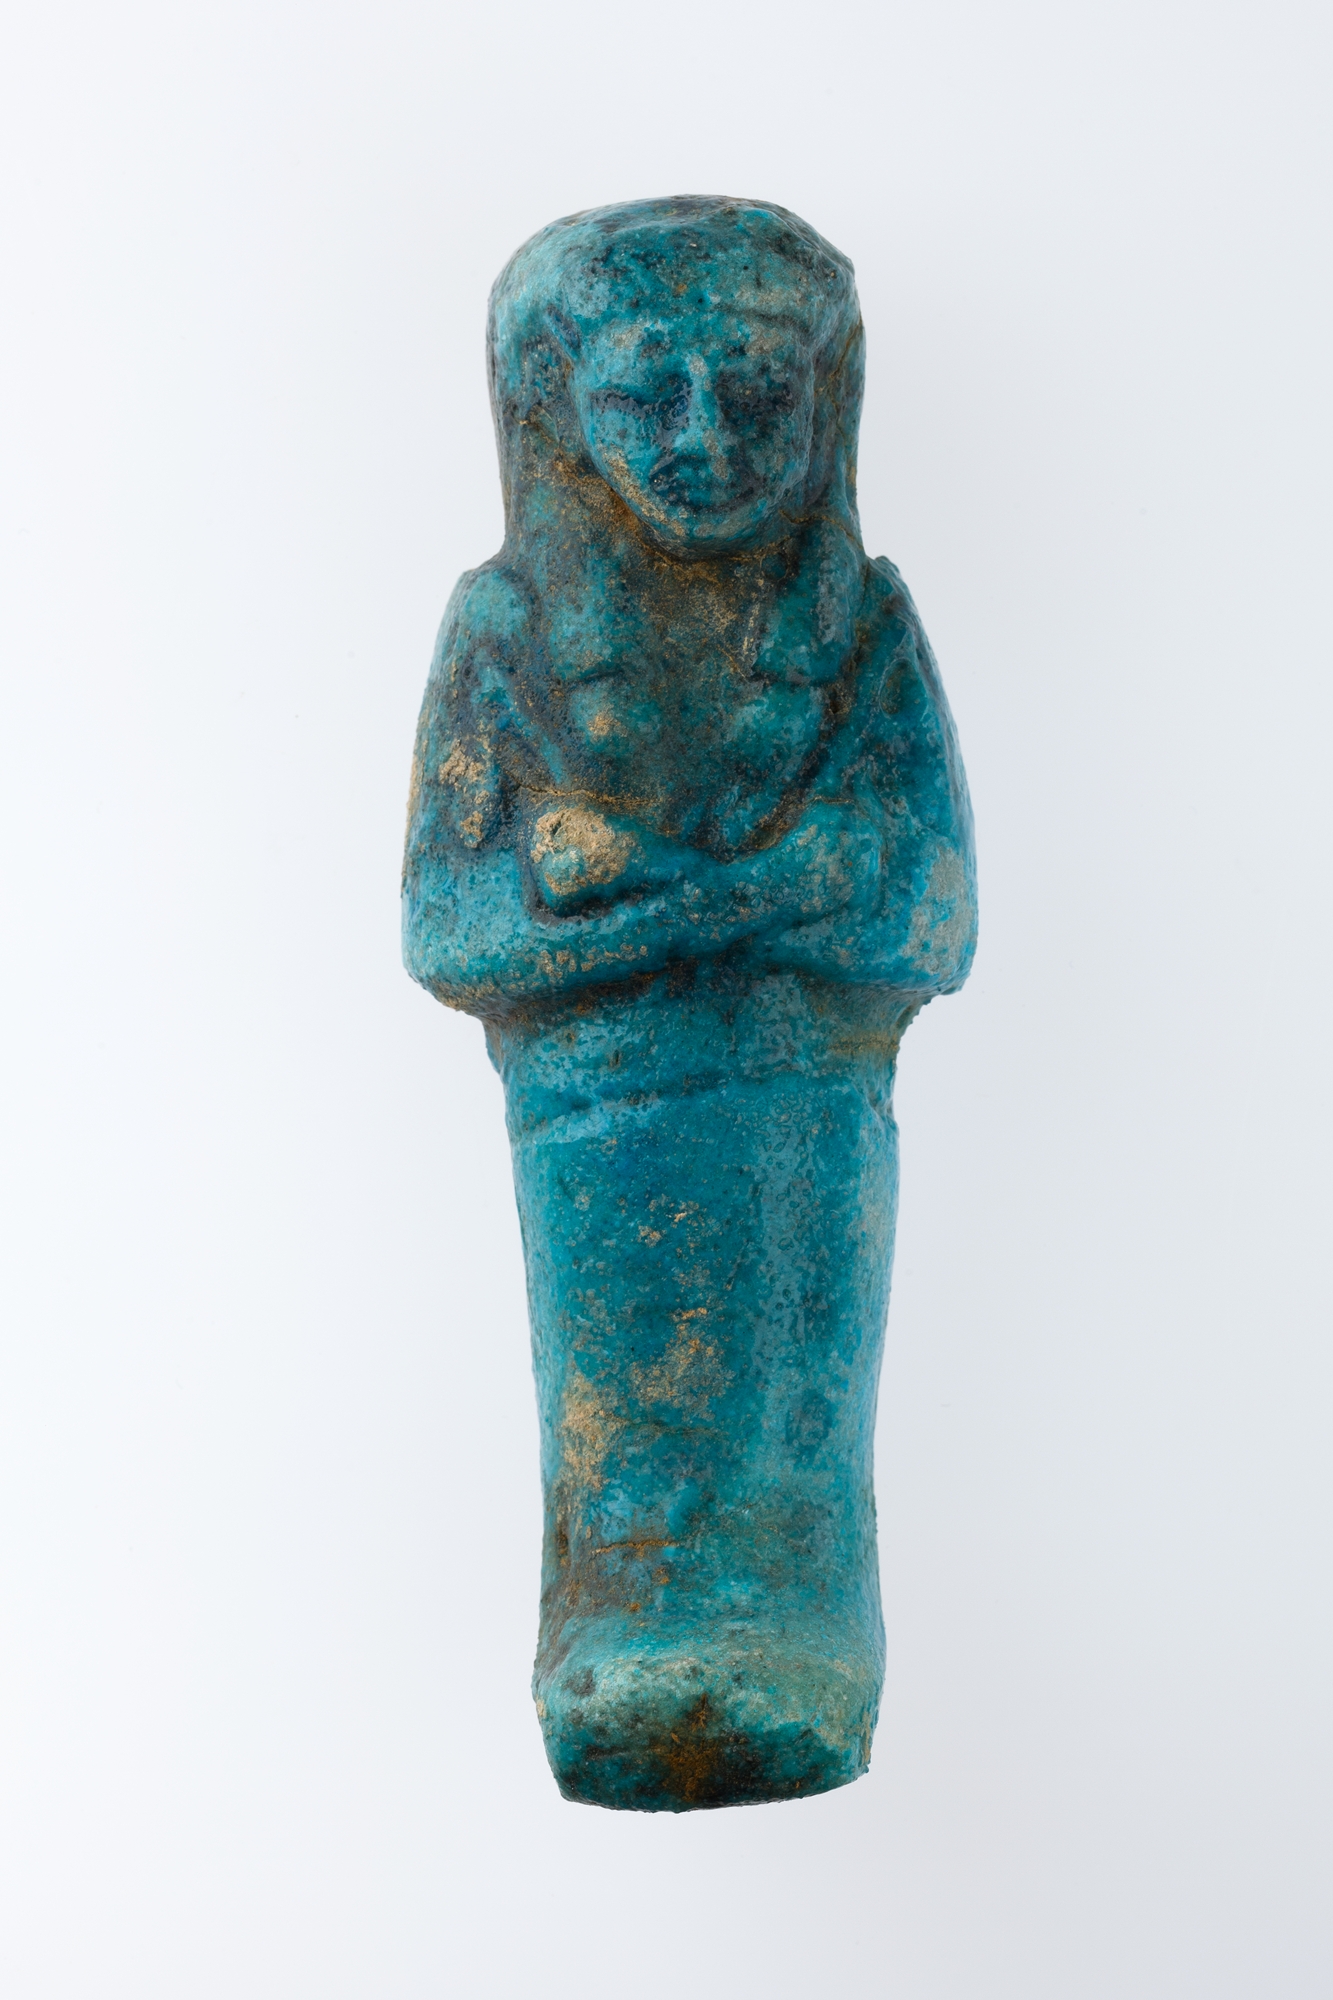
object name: shabti, henettawy c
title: Worker Shabti of Henettawy (C), Daughter of Isetemkheb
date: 990-970 BCE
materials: faience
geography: egypt